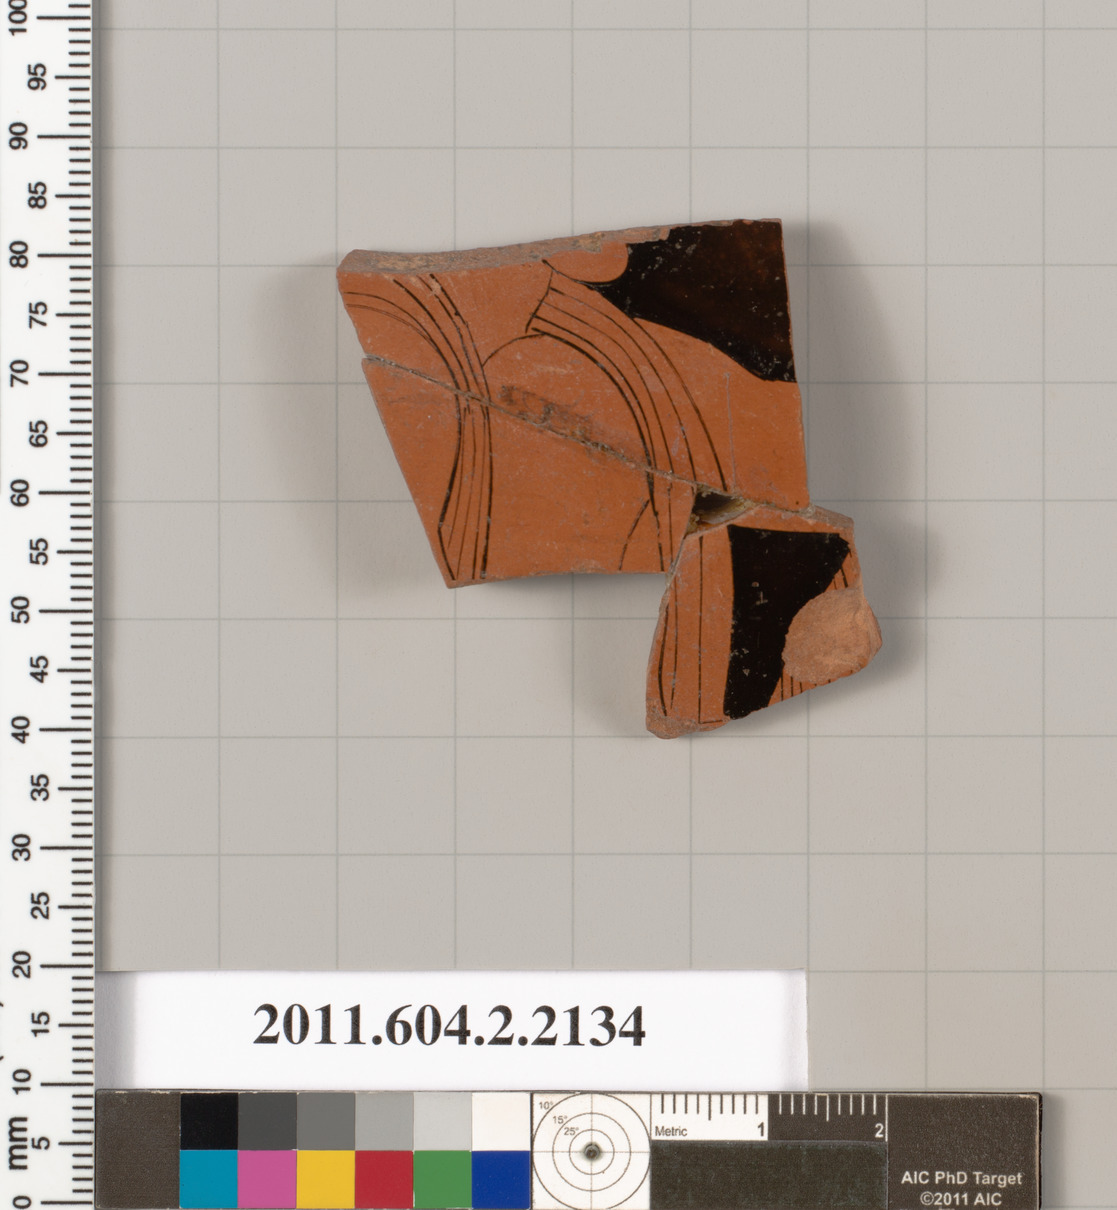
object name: pot fragment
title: Terracotta fragment of a pot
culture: greek, attic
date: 480-470 BCE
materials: terracotta